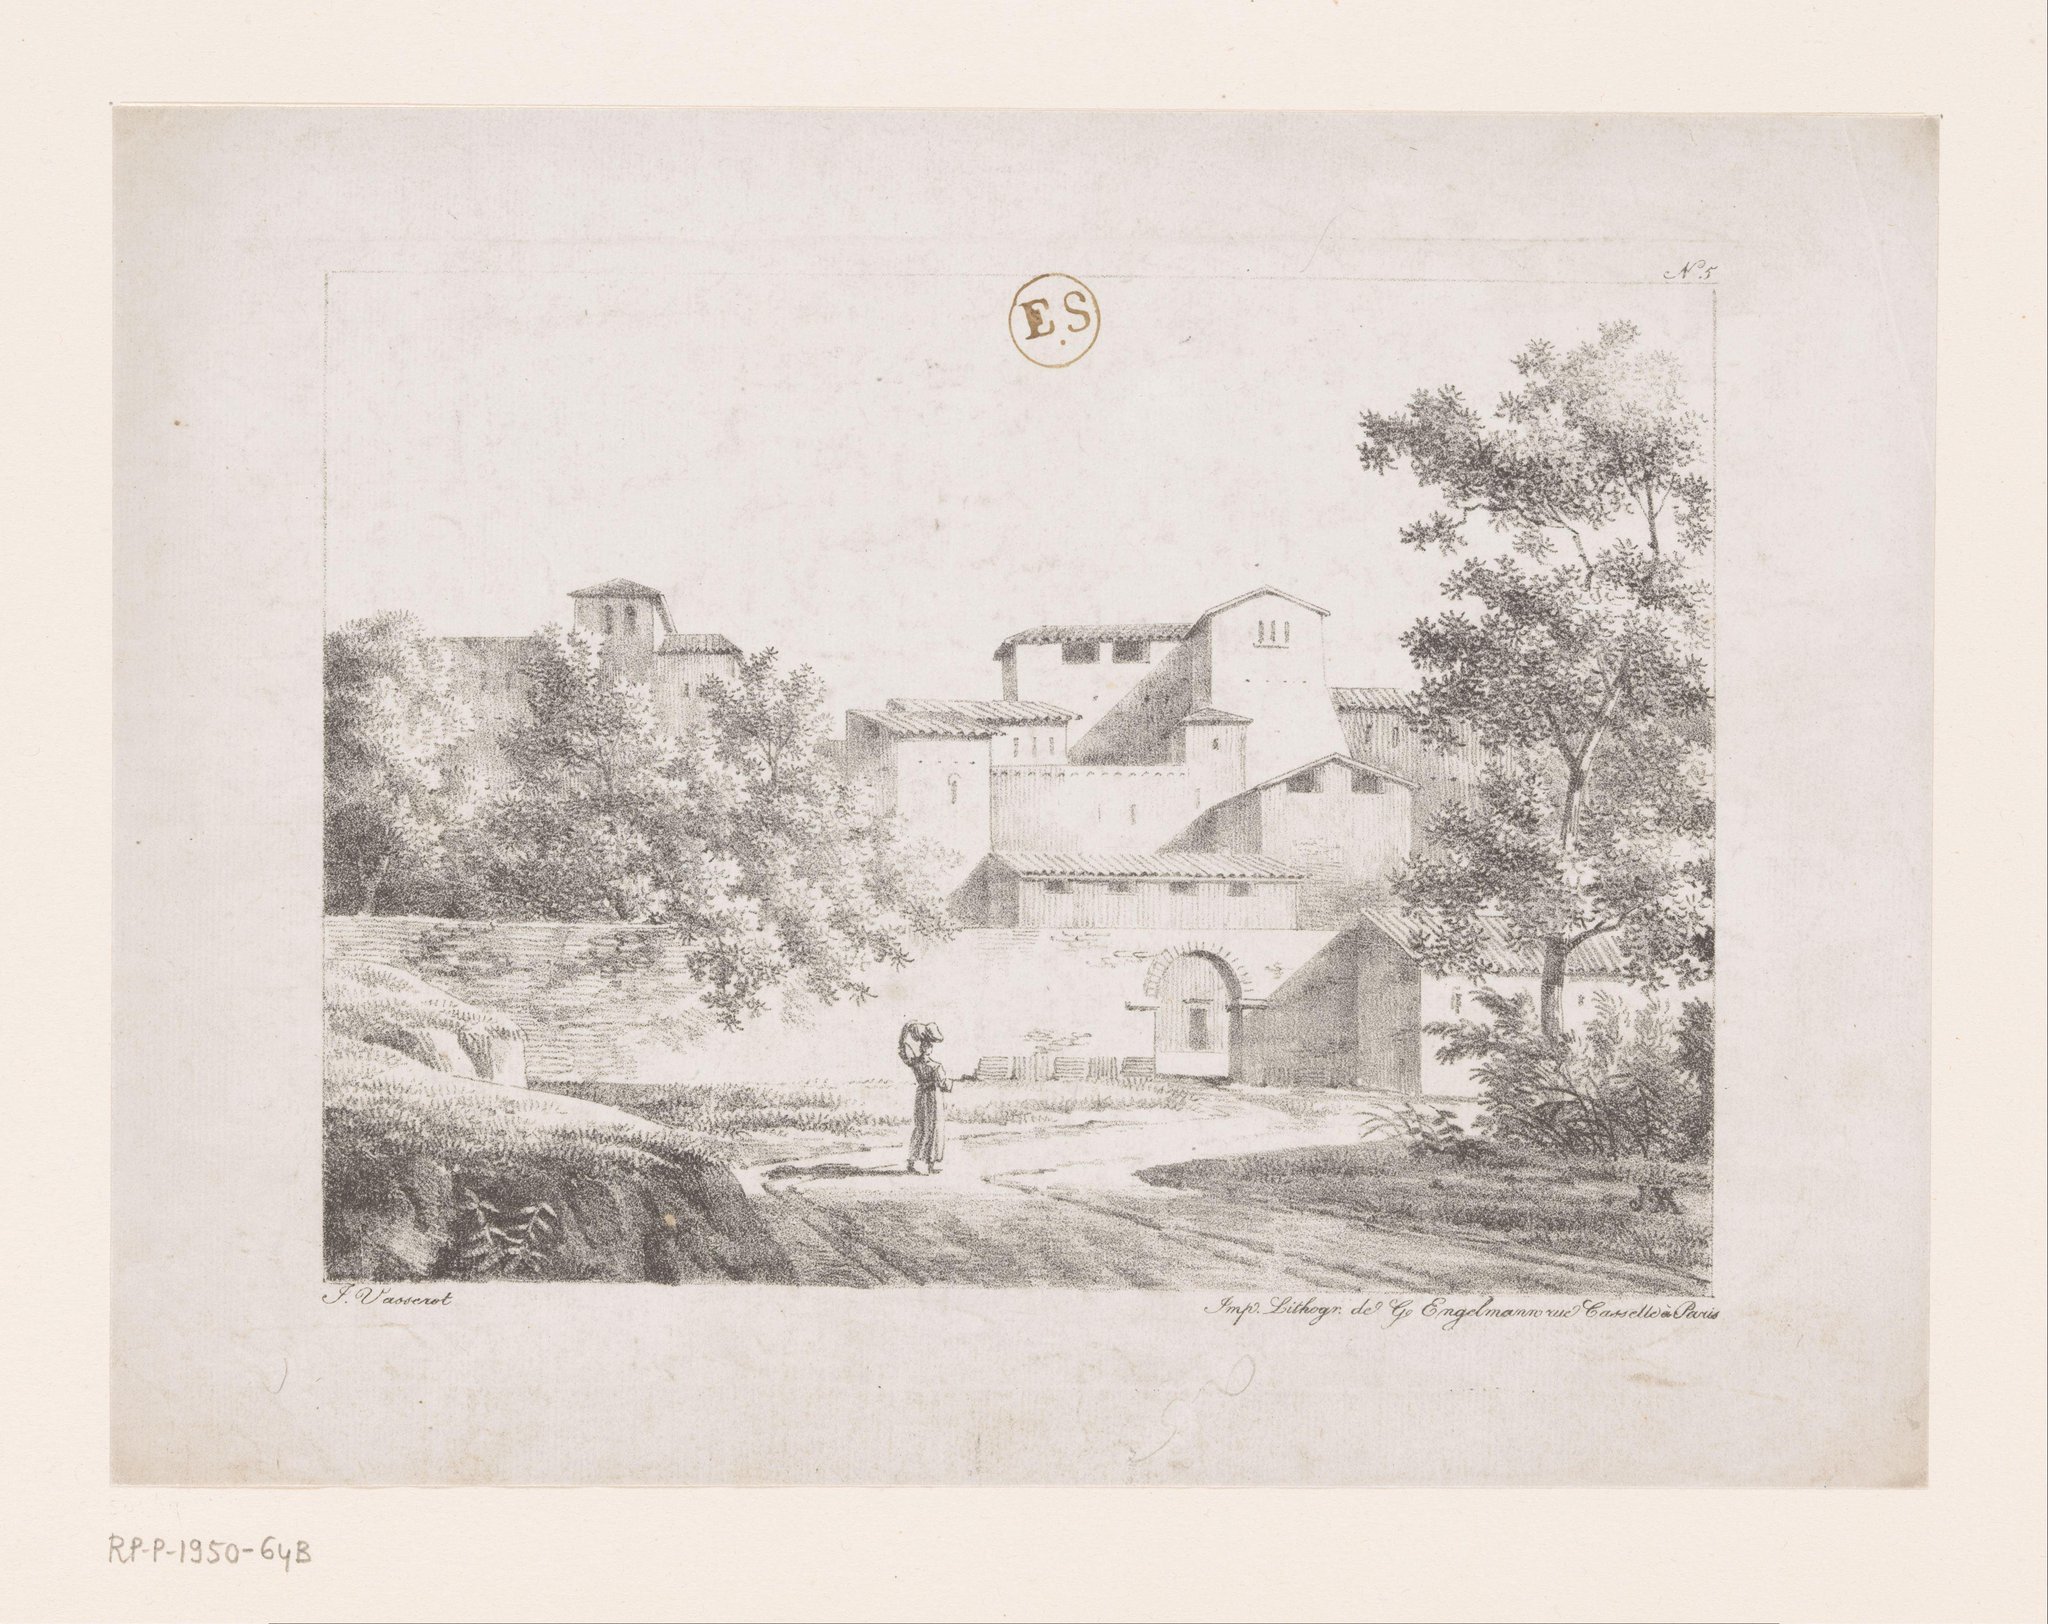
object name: print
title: Zicht op een ommuurde Italiaanse stad vanaf een toegangsweg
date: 1816-1830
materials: paper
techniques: lithograph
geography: paris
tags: village-gate (+ city(-scape) with figures, staffage), prospect of village, silhouette of village (+ city(-scape) with figures, staffage), public road (+ city(-scape) with figures, staffage)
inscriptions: stamp: ‘E.S’, collector's mark: Lugt 2228a